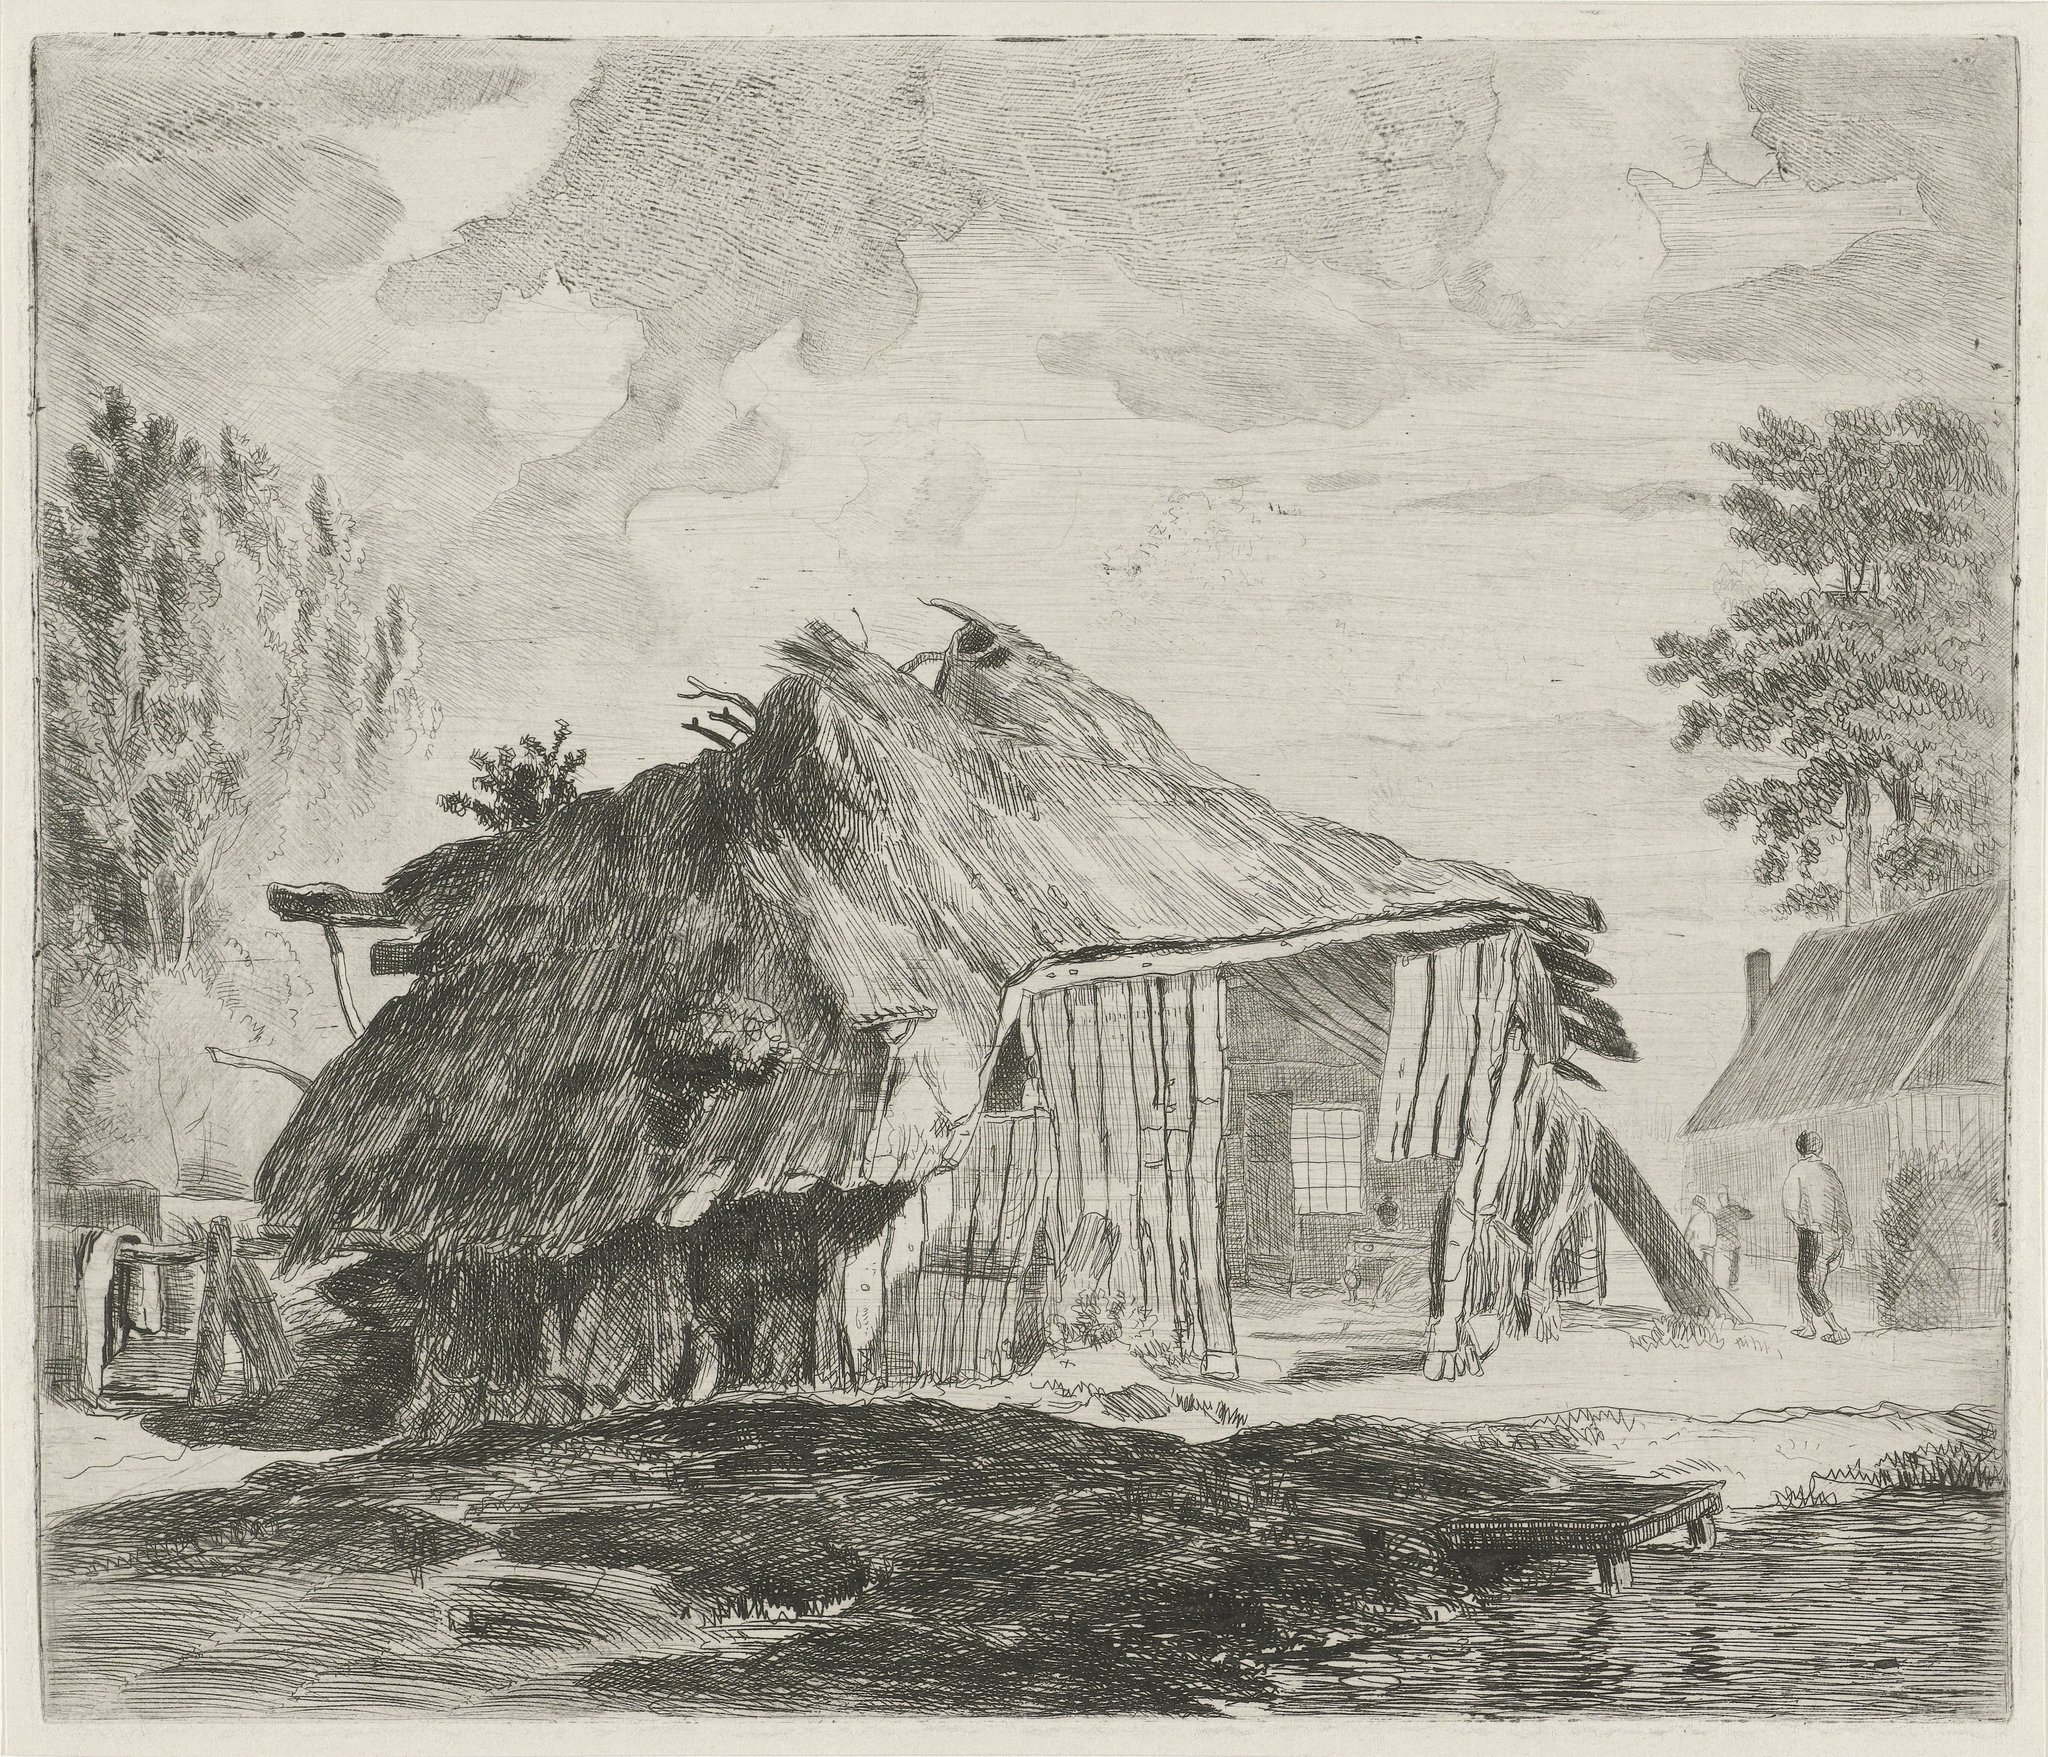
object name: print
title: Schuur in een landschap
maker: cornelis van der griendt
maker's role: draughtsman, painter, print maker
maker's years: 1827-1918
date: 1858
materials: paper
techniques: drypoint, etching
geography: netherlands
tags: barn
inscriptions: collector's mark: Lugt 2228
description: Schuur in een landschap aan water gelegen. Aan de rechterzijde drie figuren.